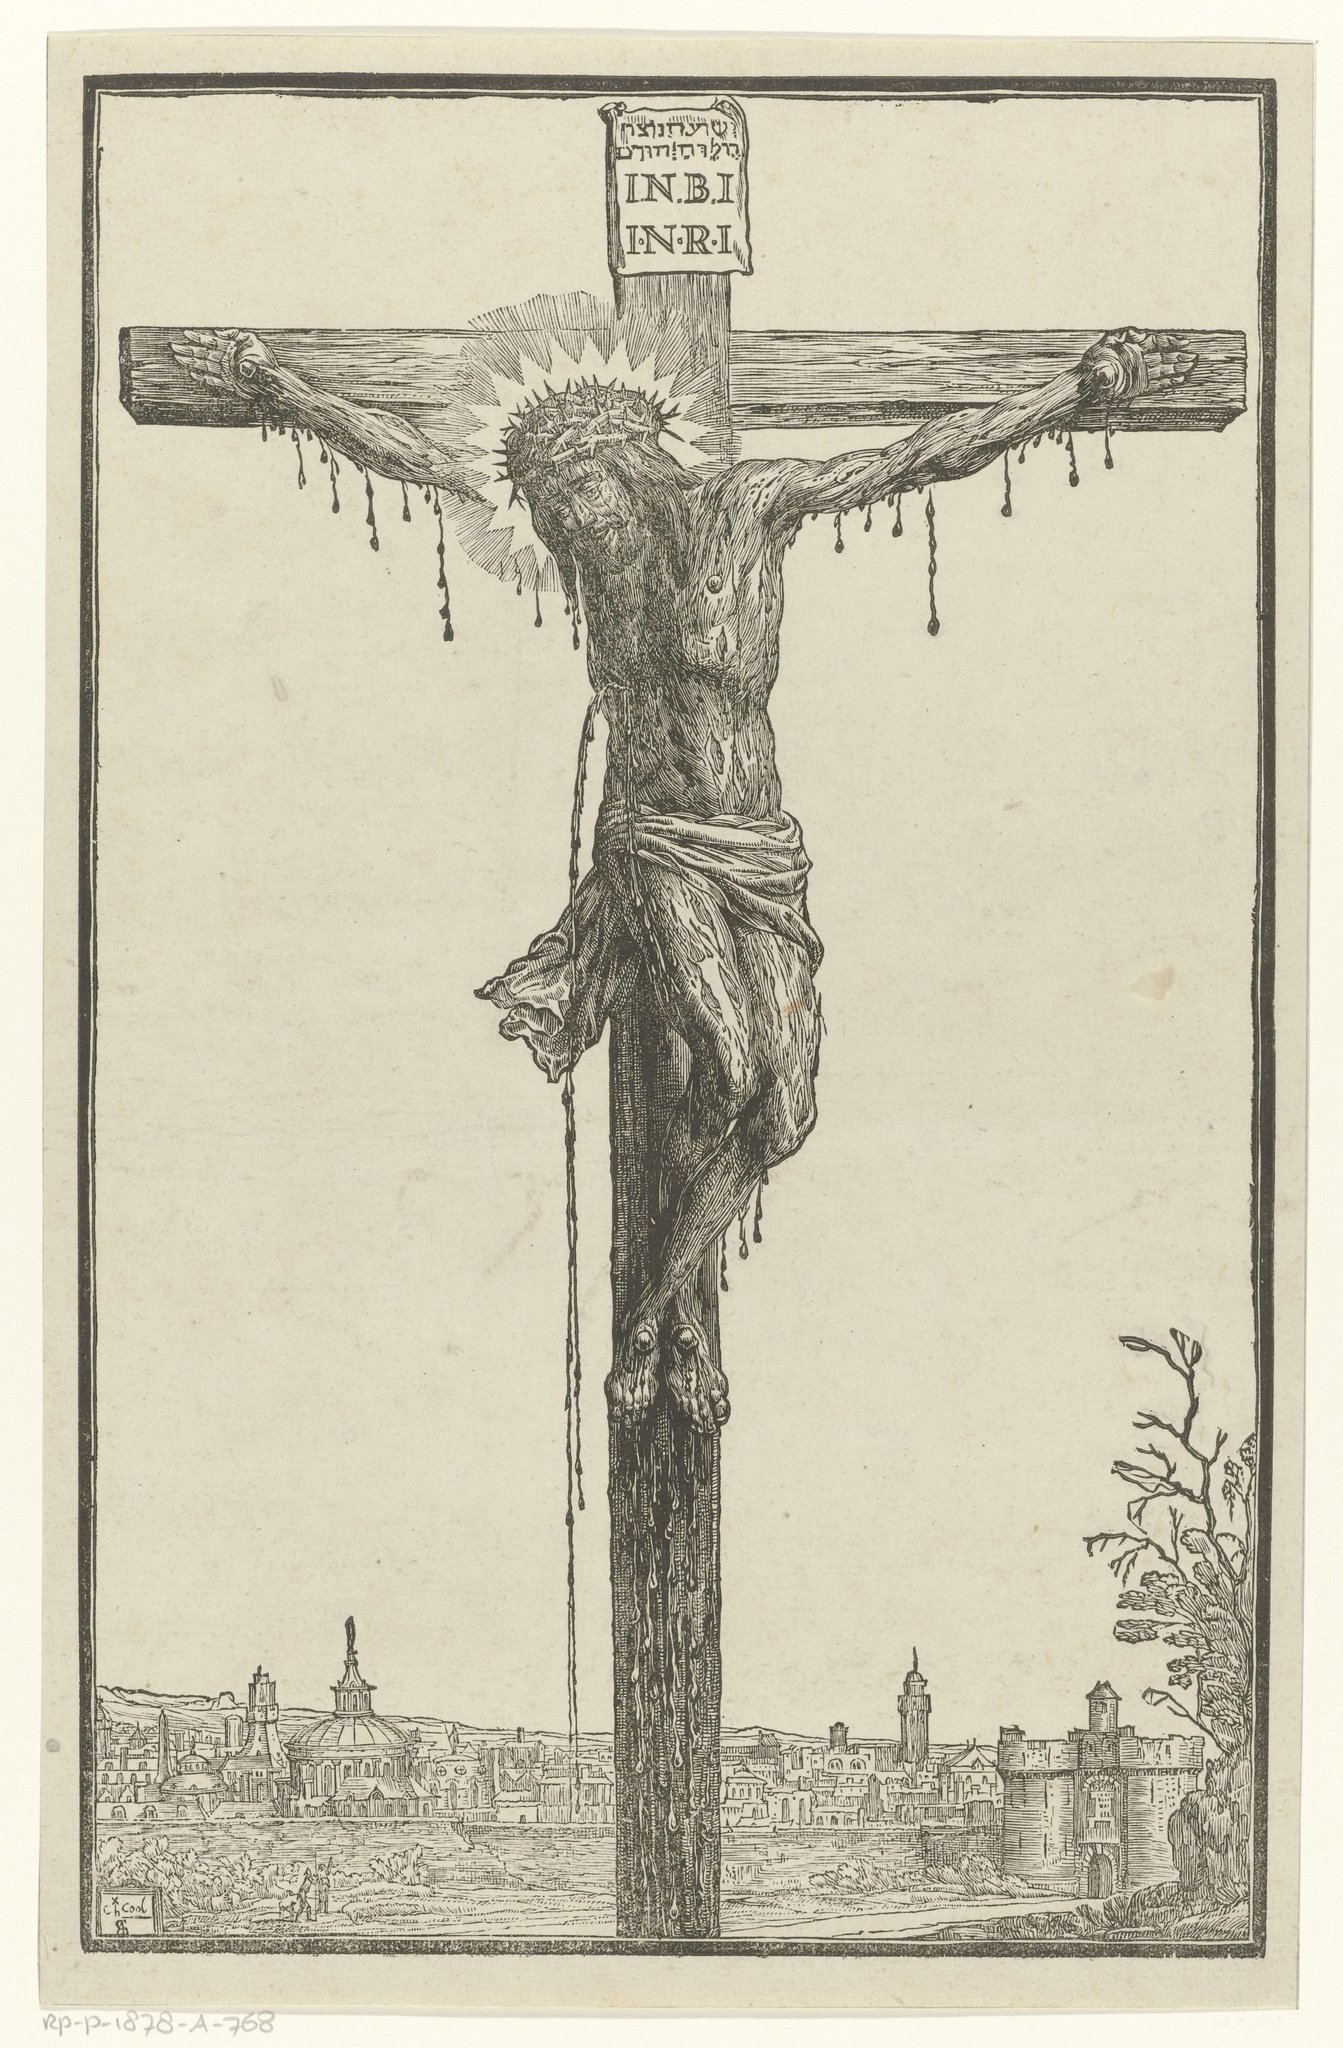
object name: print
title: Christus aan het kruis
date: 1600-1699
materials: paper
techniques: woodcut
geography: netherlands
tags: the crucifixion of christ: christ's death on the cross; golgotha (matthew 27:45-58; mark 15:33-45; luke 23:44-52; john 19:25-38)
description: Christus aan het kruis genageld, het bloed stroomt op verschillende plaatsen uit zijn lichaam. Op de achtergrond de stad Jeruzalem.